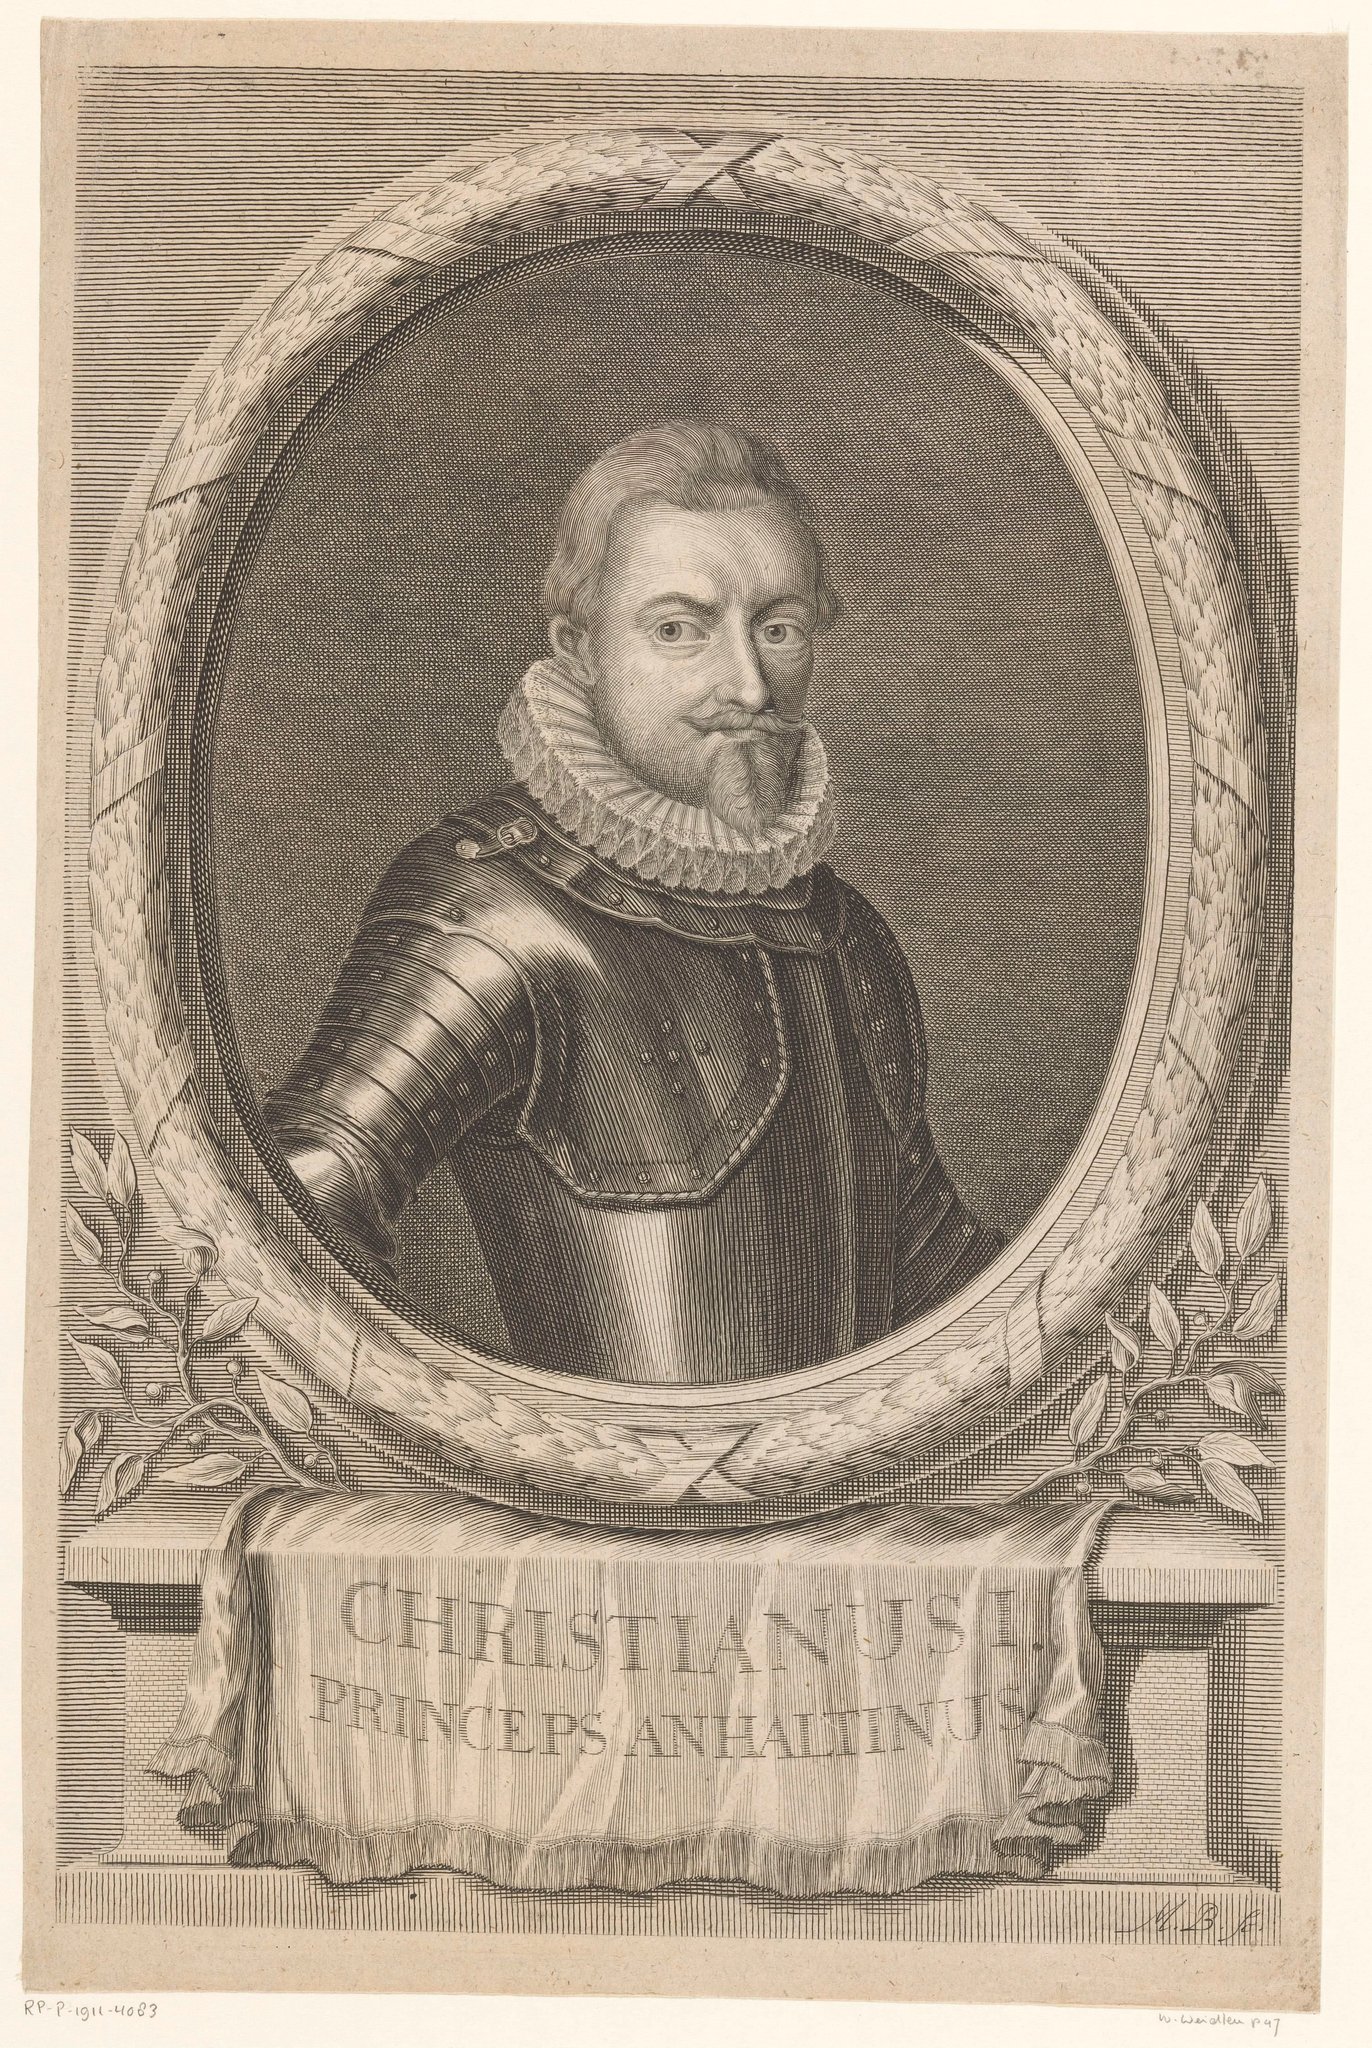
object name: print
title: Christian I von Anhalt-Bernburg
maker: martin bernigeroth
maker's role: print maker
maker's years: 1670-1733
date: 1680-1733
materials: paper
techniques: engraving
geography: leipzig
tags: armour, historical persons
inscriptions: collector's mark: Lugt 2228